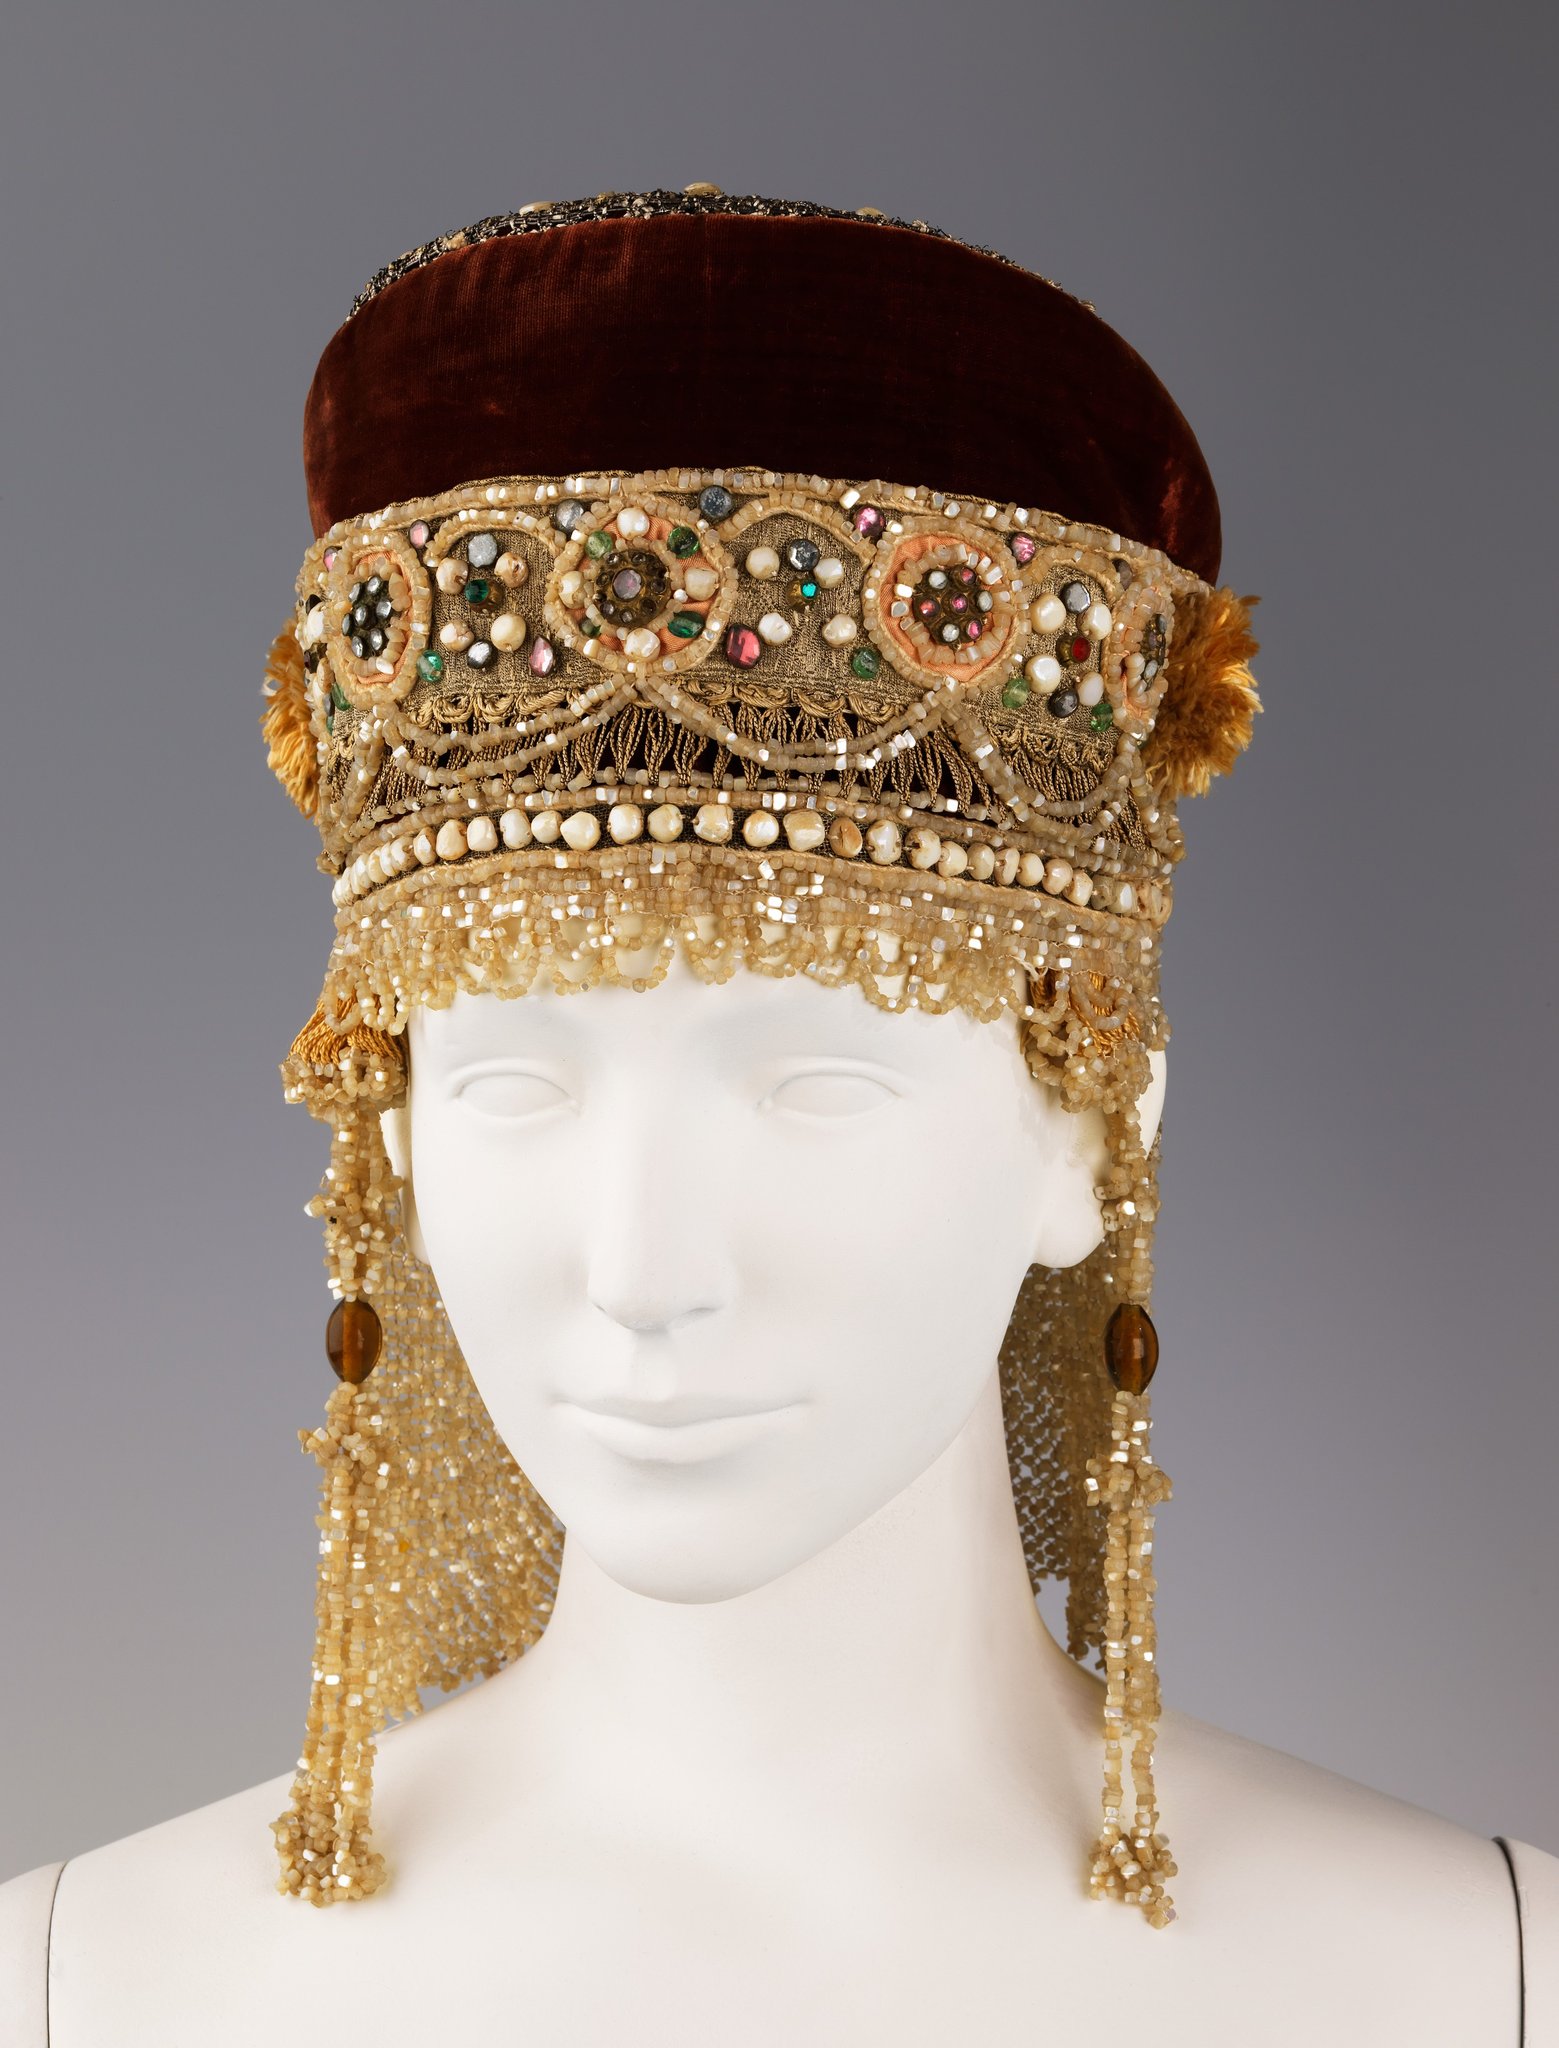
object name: headdress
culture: russian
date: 1801-1900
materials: metal, mother of pearl, pearl, silk